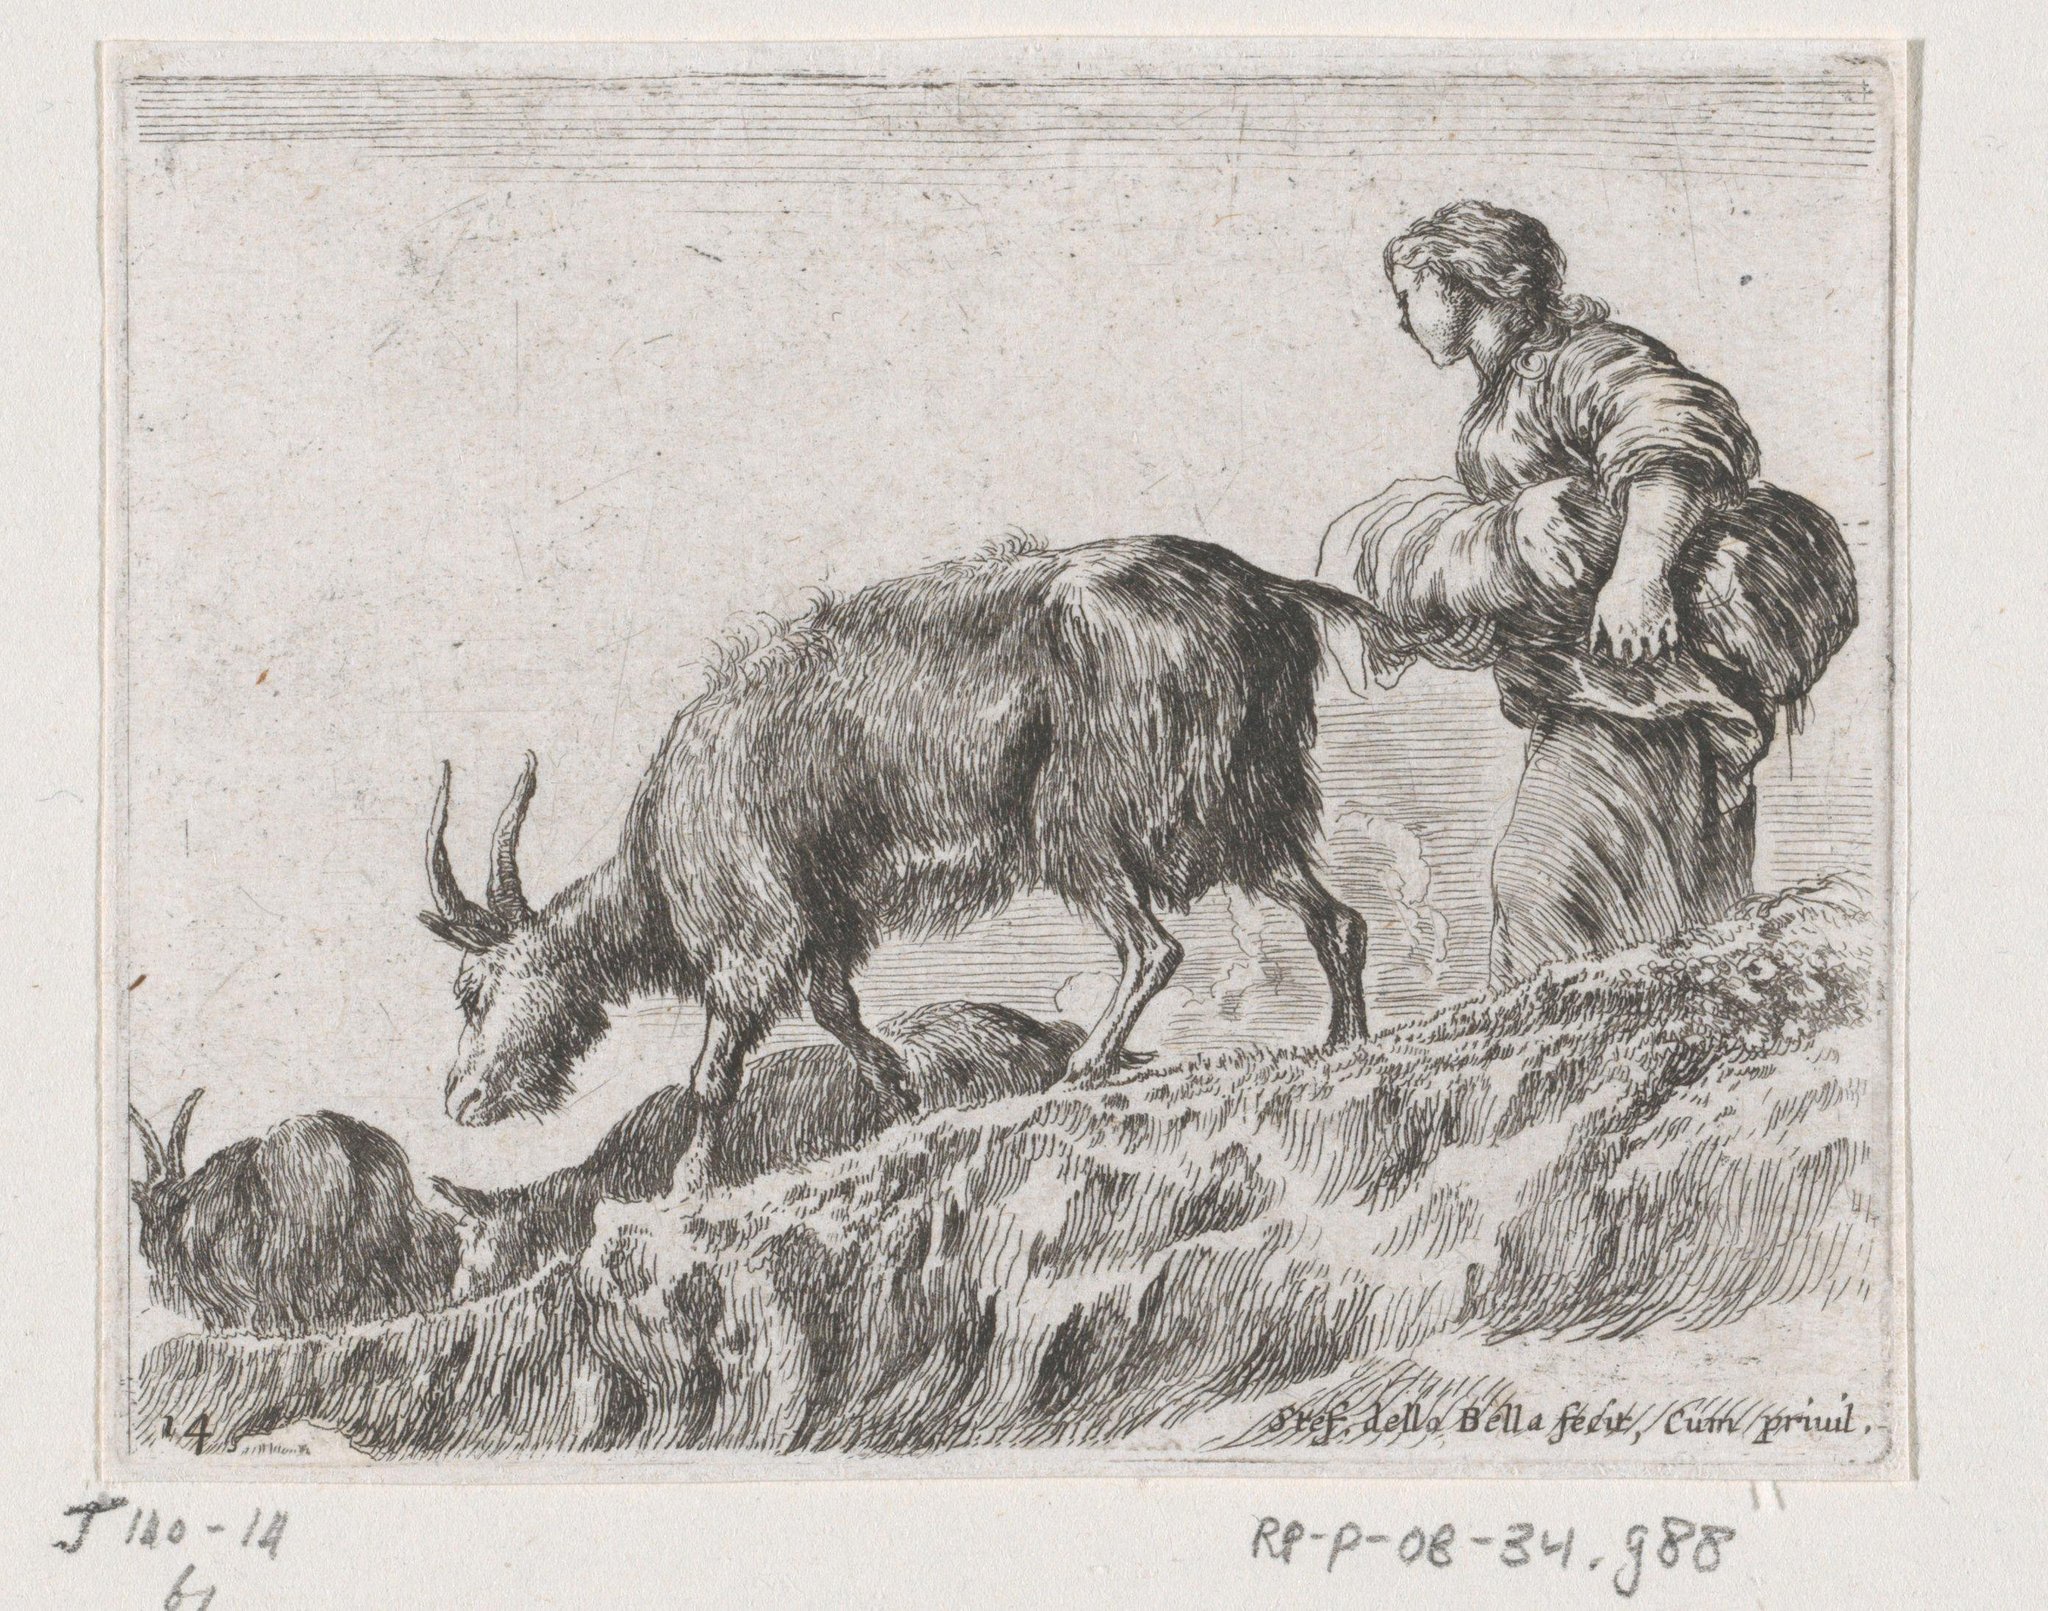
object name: print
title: Diversi animali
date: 1620-1664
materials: paper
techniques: etching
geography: france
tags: animals, herding, herdsman, herdswoman, shepherd, shepherdess, cowherd, etc., goat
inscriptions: collector's mark: Lugt 240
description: Drie geiten lopen een heuvel af naar links. Achteraan loopt de hoedster.